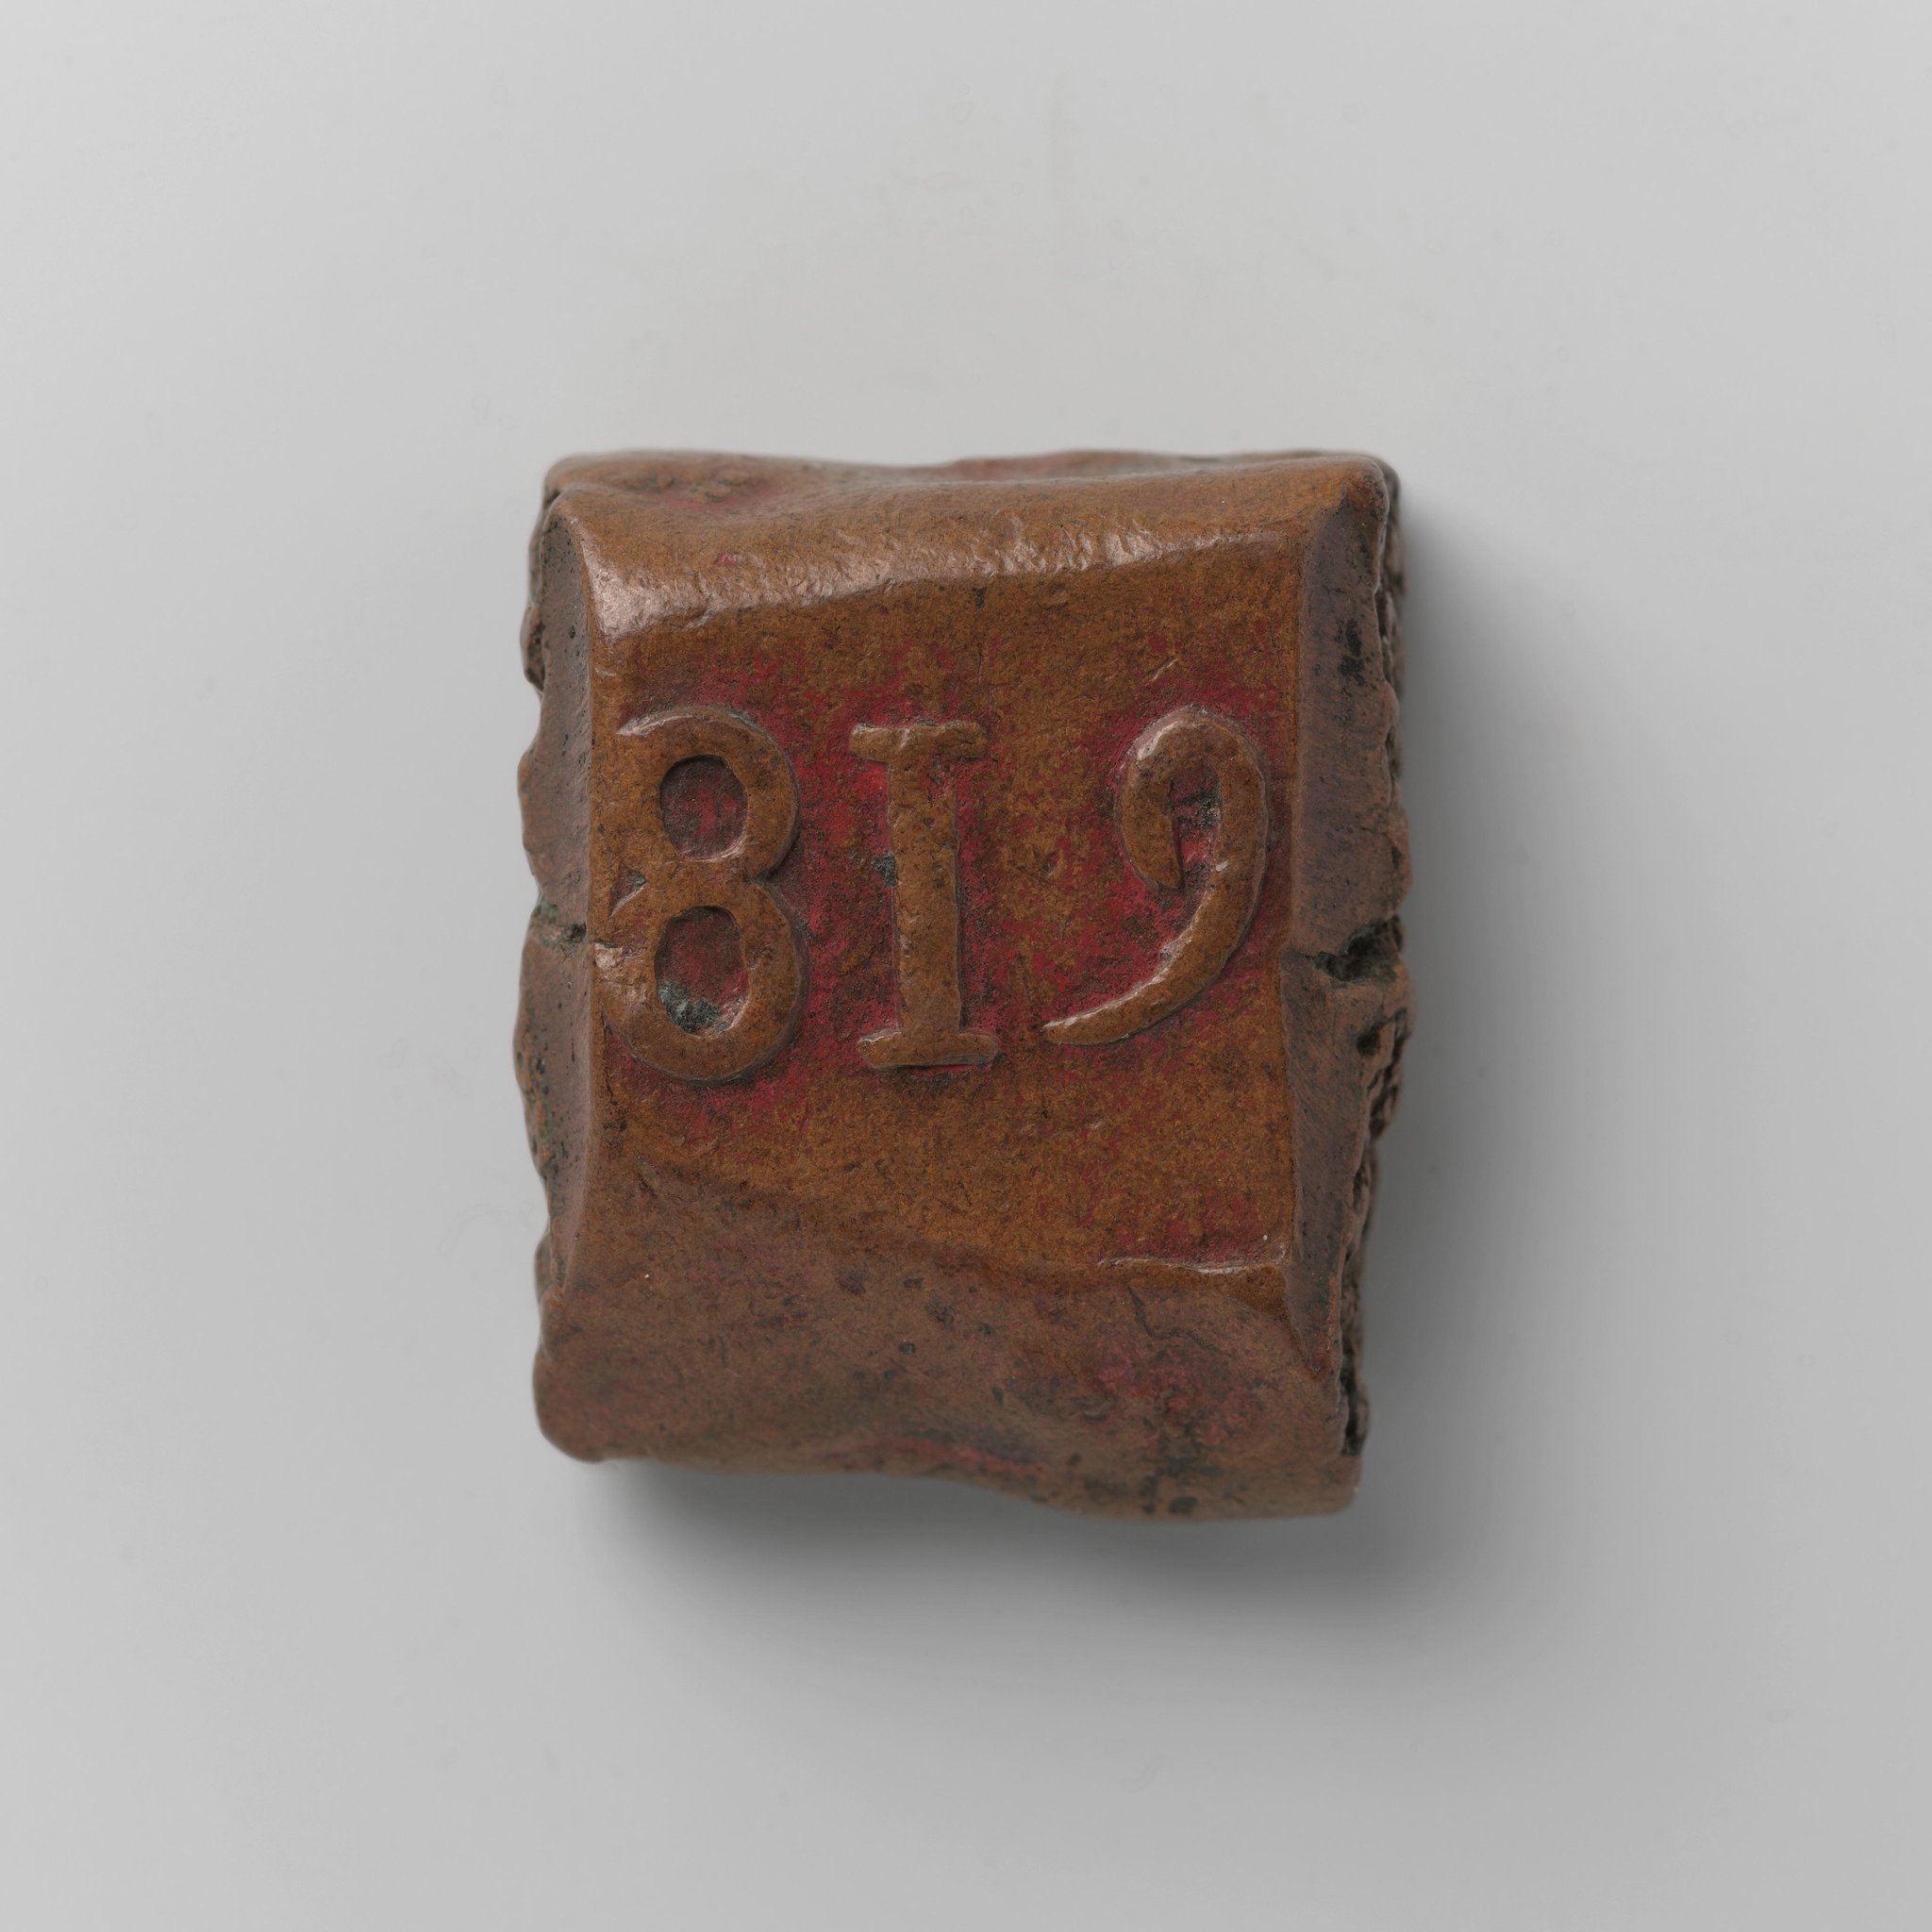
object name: coin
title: Bonk van 2 stuivers van Nederlands Indië,1819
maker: william i of the netherlands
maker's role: koning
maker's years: 1772-1843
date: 1818-1819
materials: copper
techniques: striking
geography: surabaya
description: Koperen rechthoekige munt. Voorzijde: binnen een rechthoekige lijst waarde-aanduiding 2 St. Keerzijde: binnen een rechthoekige lijst jaartal.